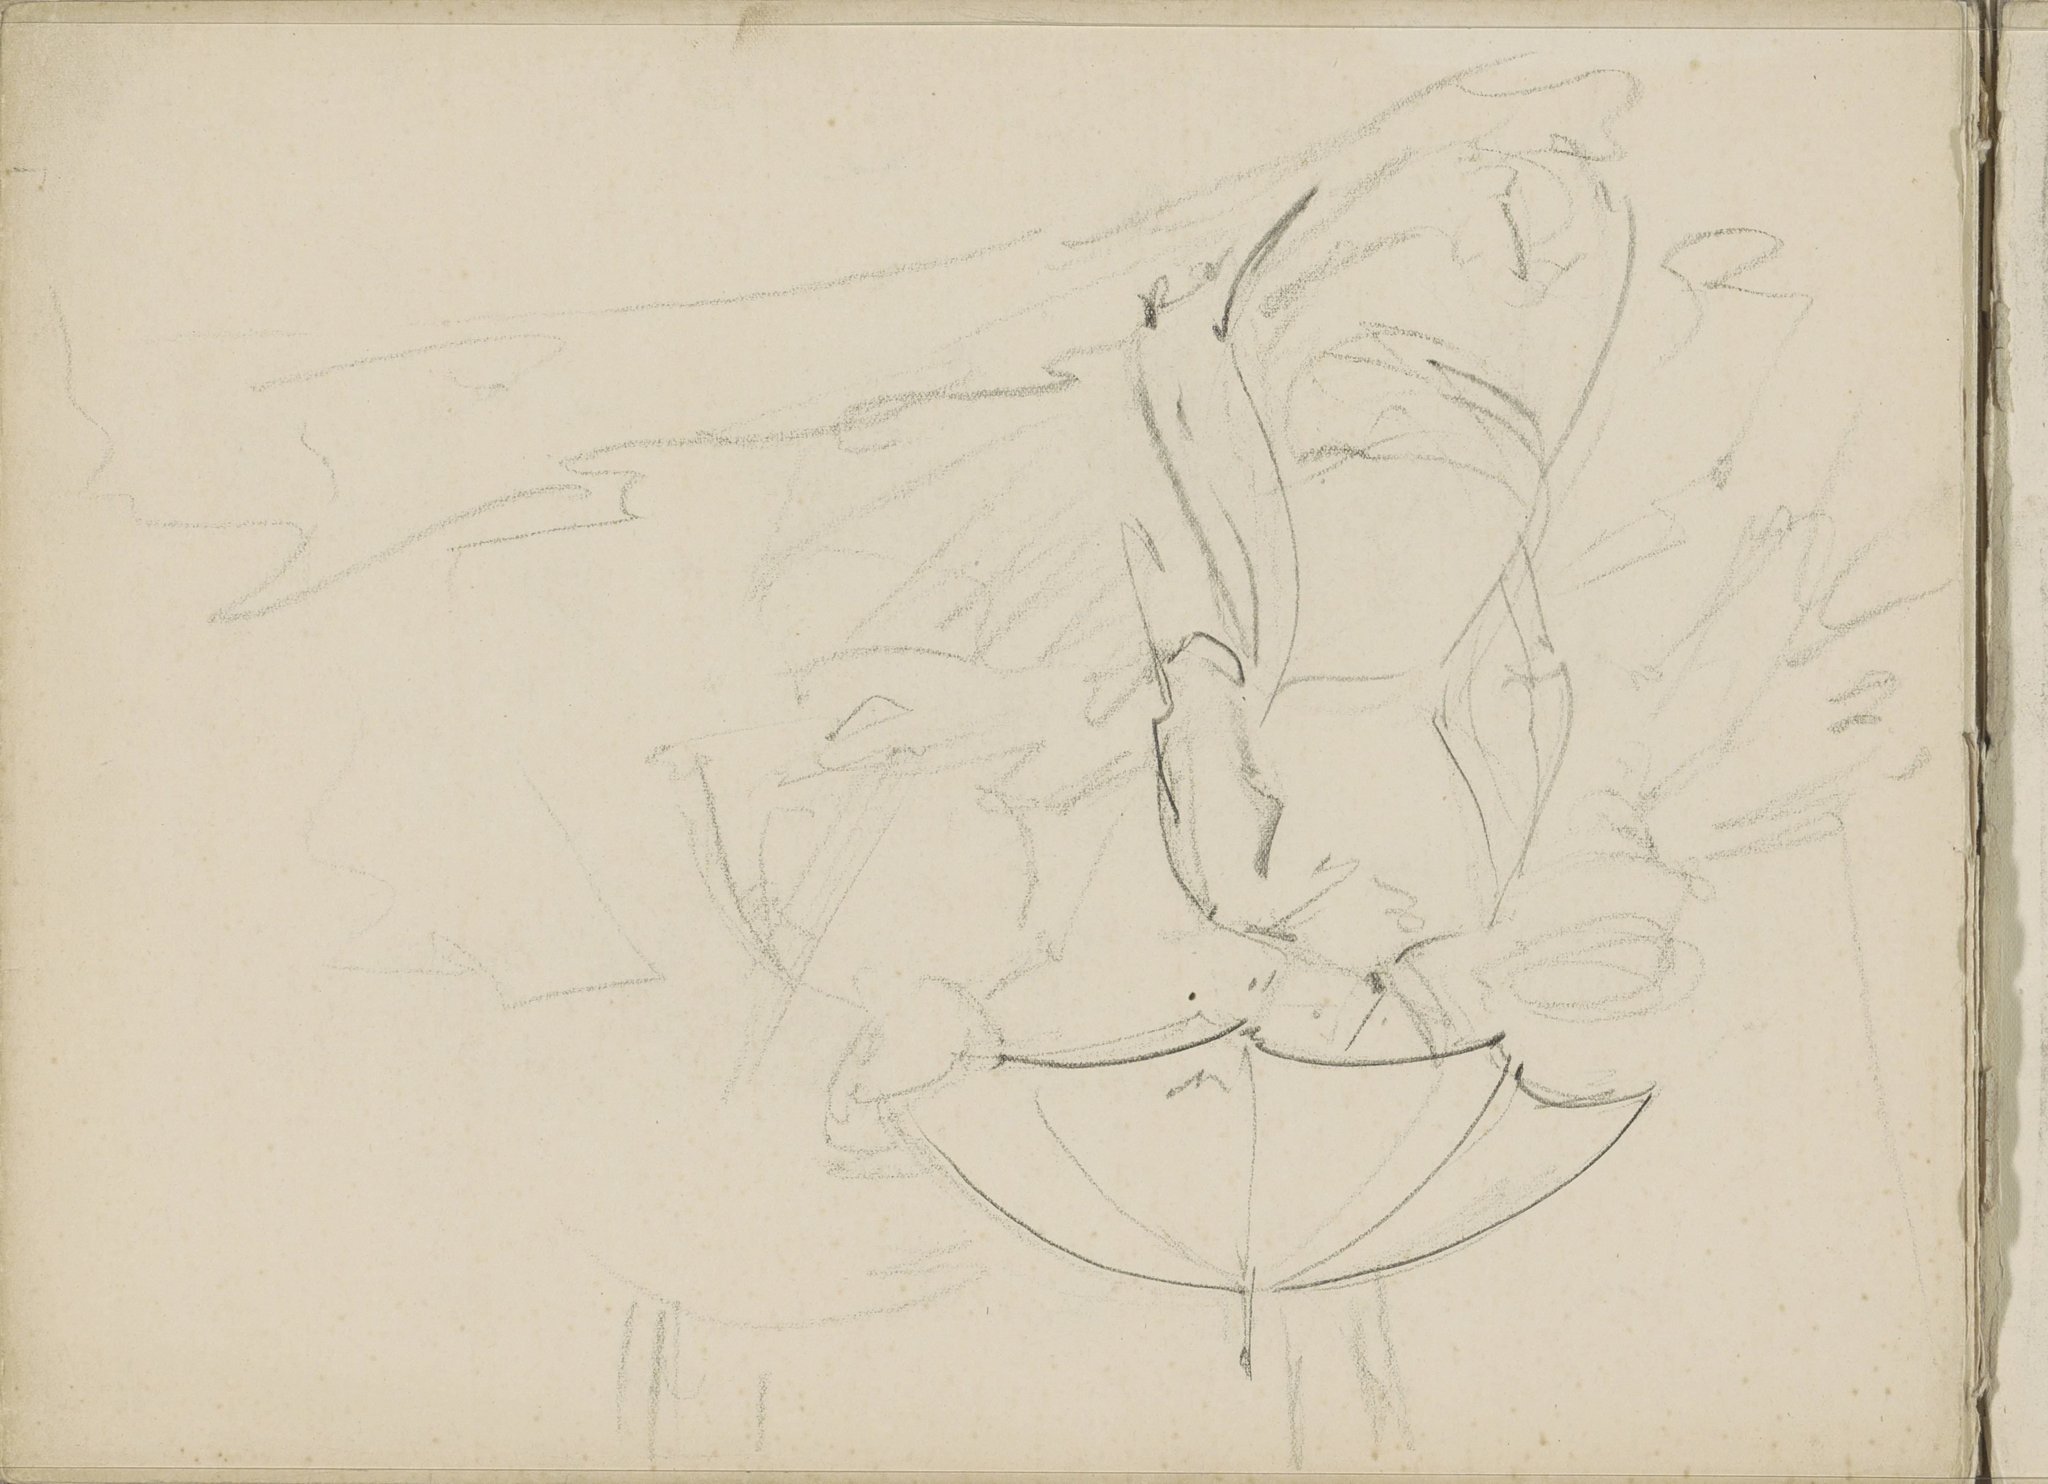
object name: sketchbook leaf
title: Twee vrouwen met parasols op het strand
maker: monogrammist ds (tekenaar)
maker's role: draughtsman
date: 1850-1950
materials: chalk, paper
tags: beach (as place of recreation), parasol, sunshade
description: Blad 15 verso uit een schetsboek met 17 bladen.